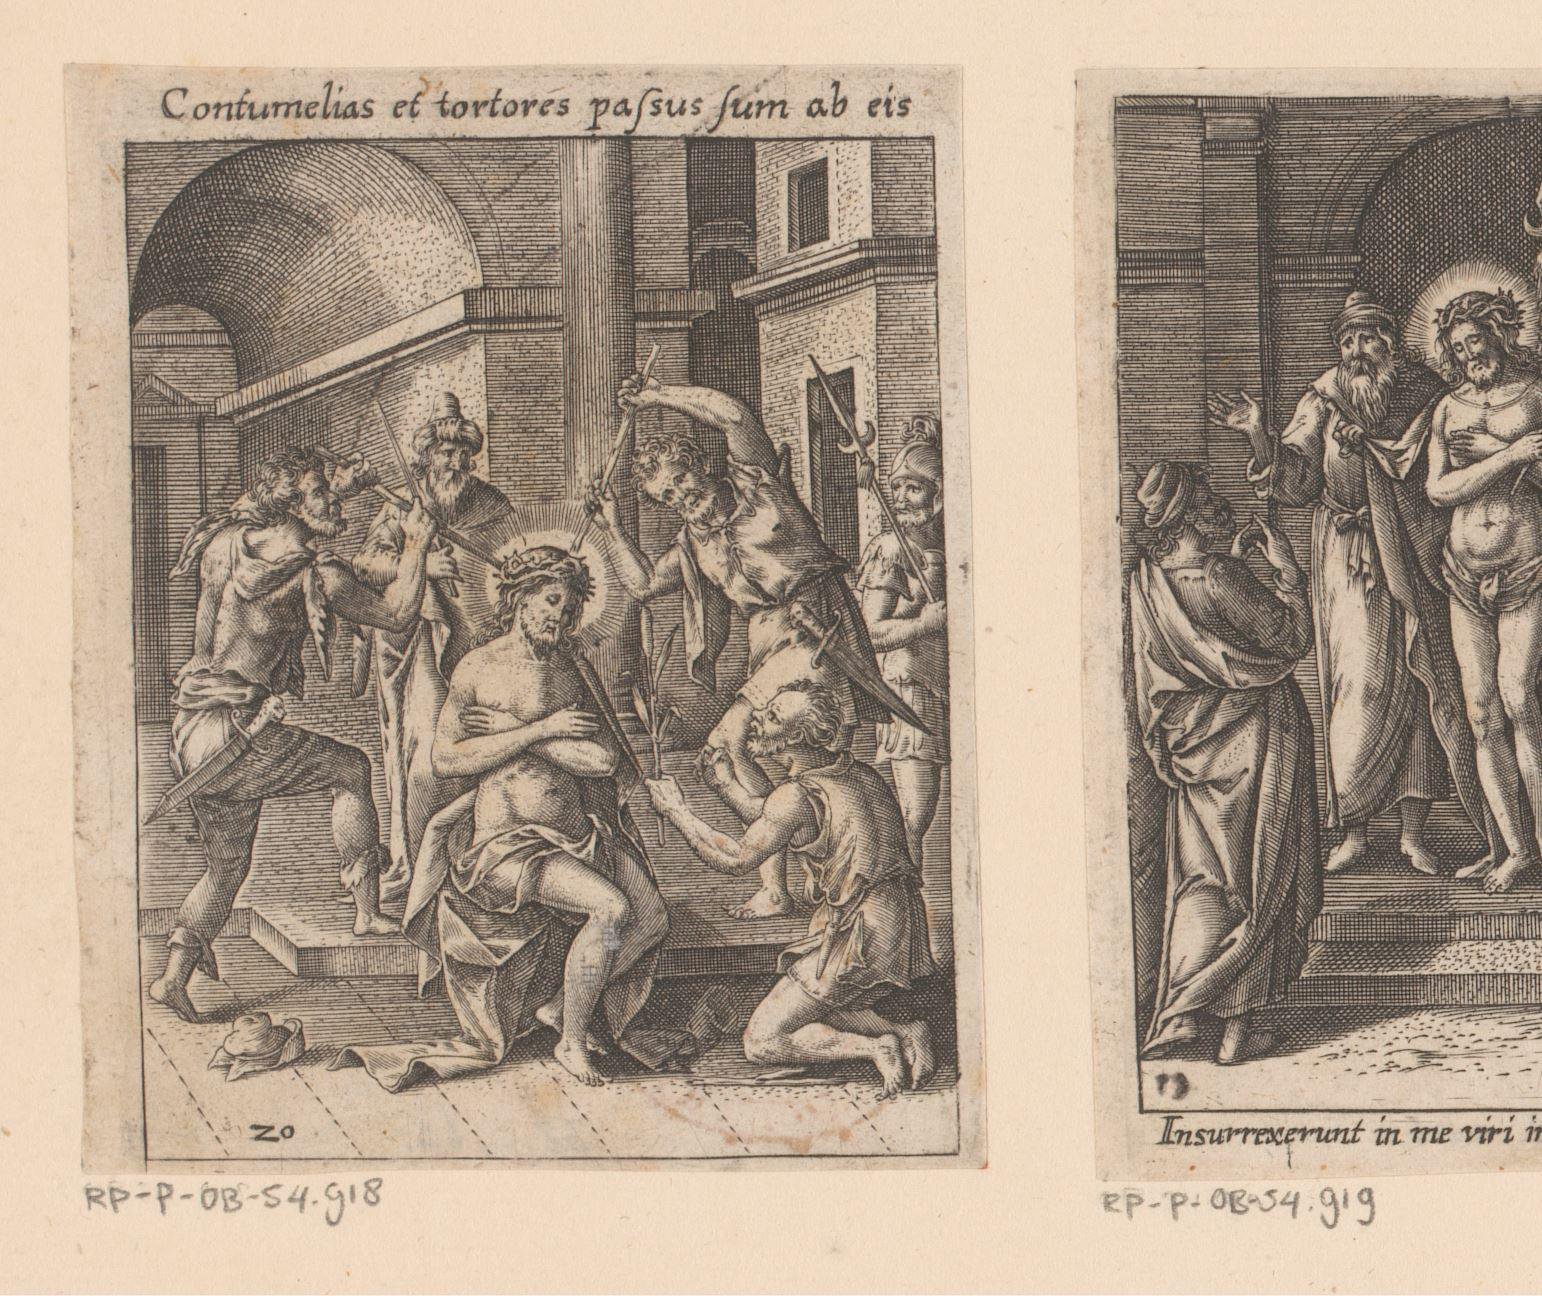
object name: print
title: Leven, passie en wederopstanding van Christus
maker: heinrich ulrich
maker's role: draughtsman, painter, print maker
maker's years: 1572-1671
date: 1582-1671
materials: paper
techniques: engraving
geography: germany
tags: the crowning with thorns: soldiers with sticks place a thorny crown on christ's head and give him a reed (matthew 27:27-31; mark 15:16-20; john 19:2-3)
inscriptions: number: ‘38. - 64.’, collector's mark: Lugt 240